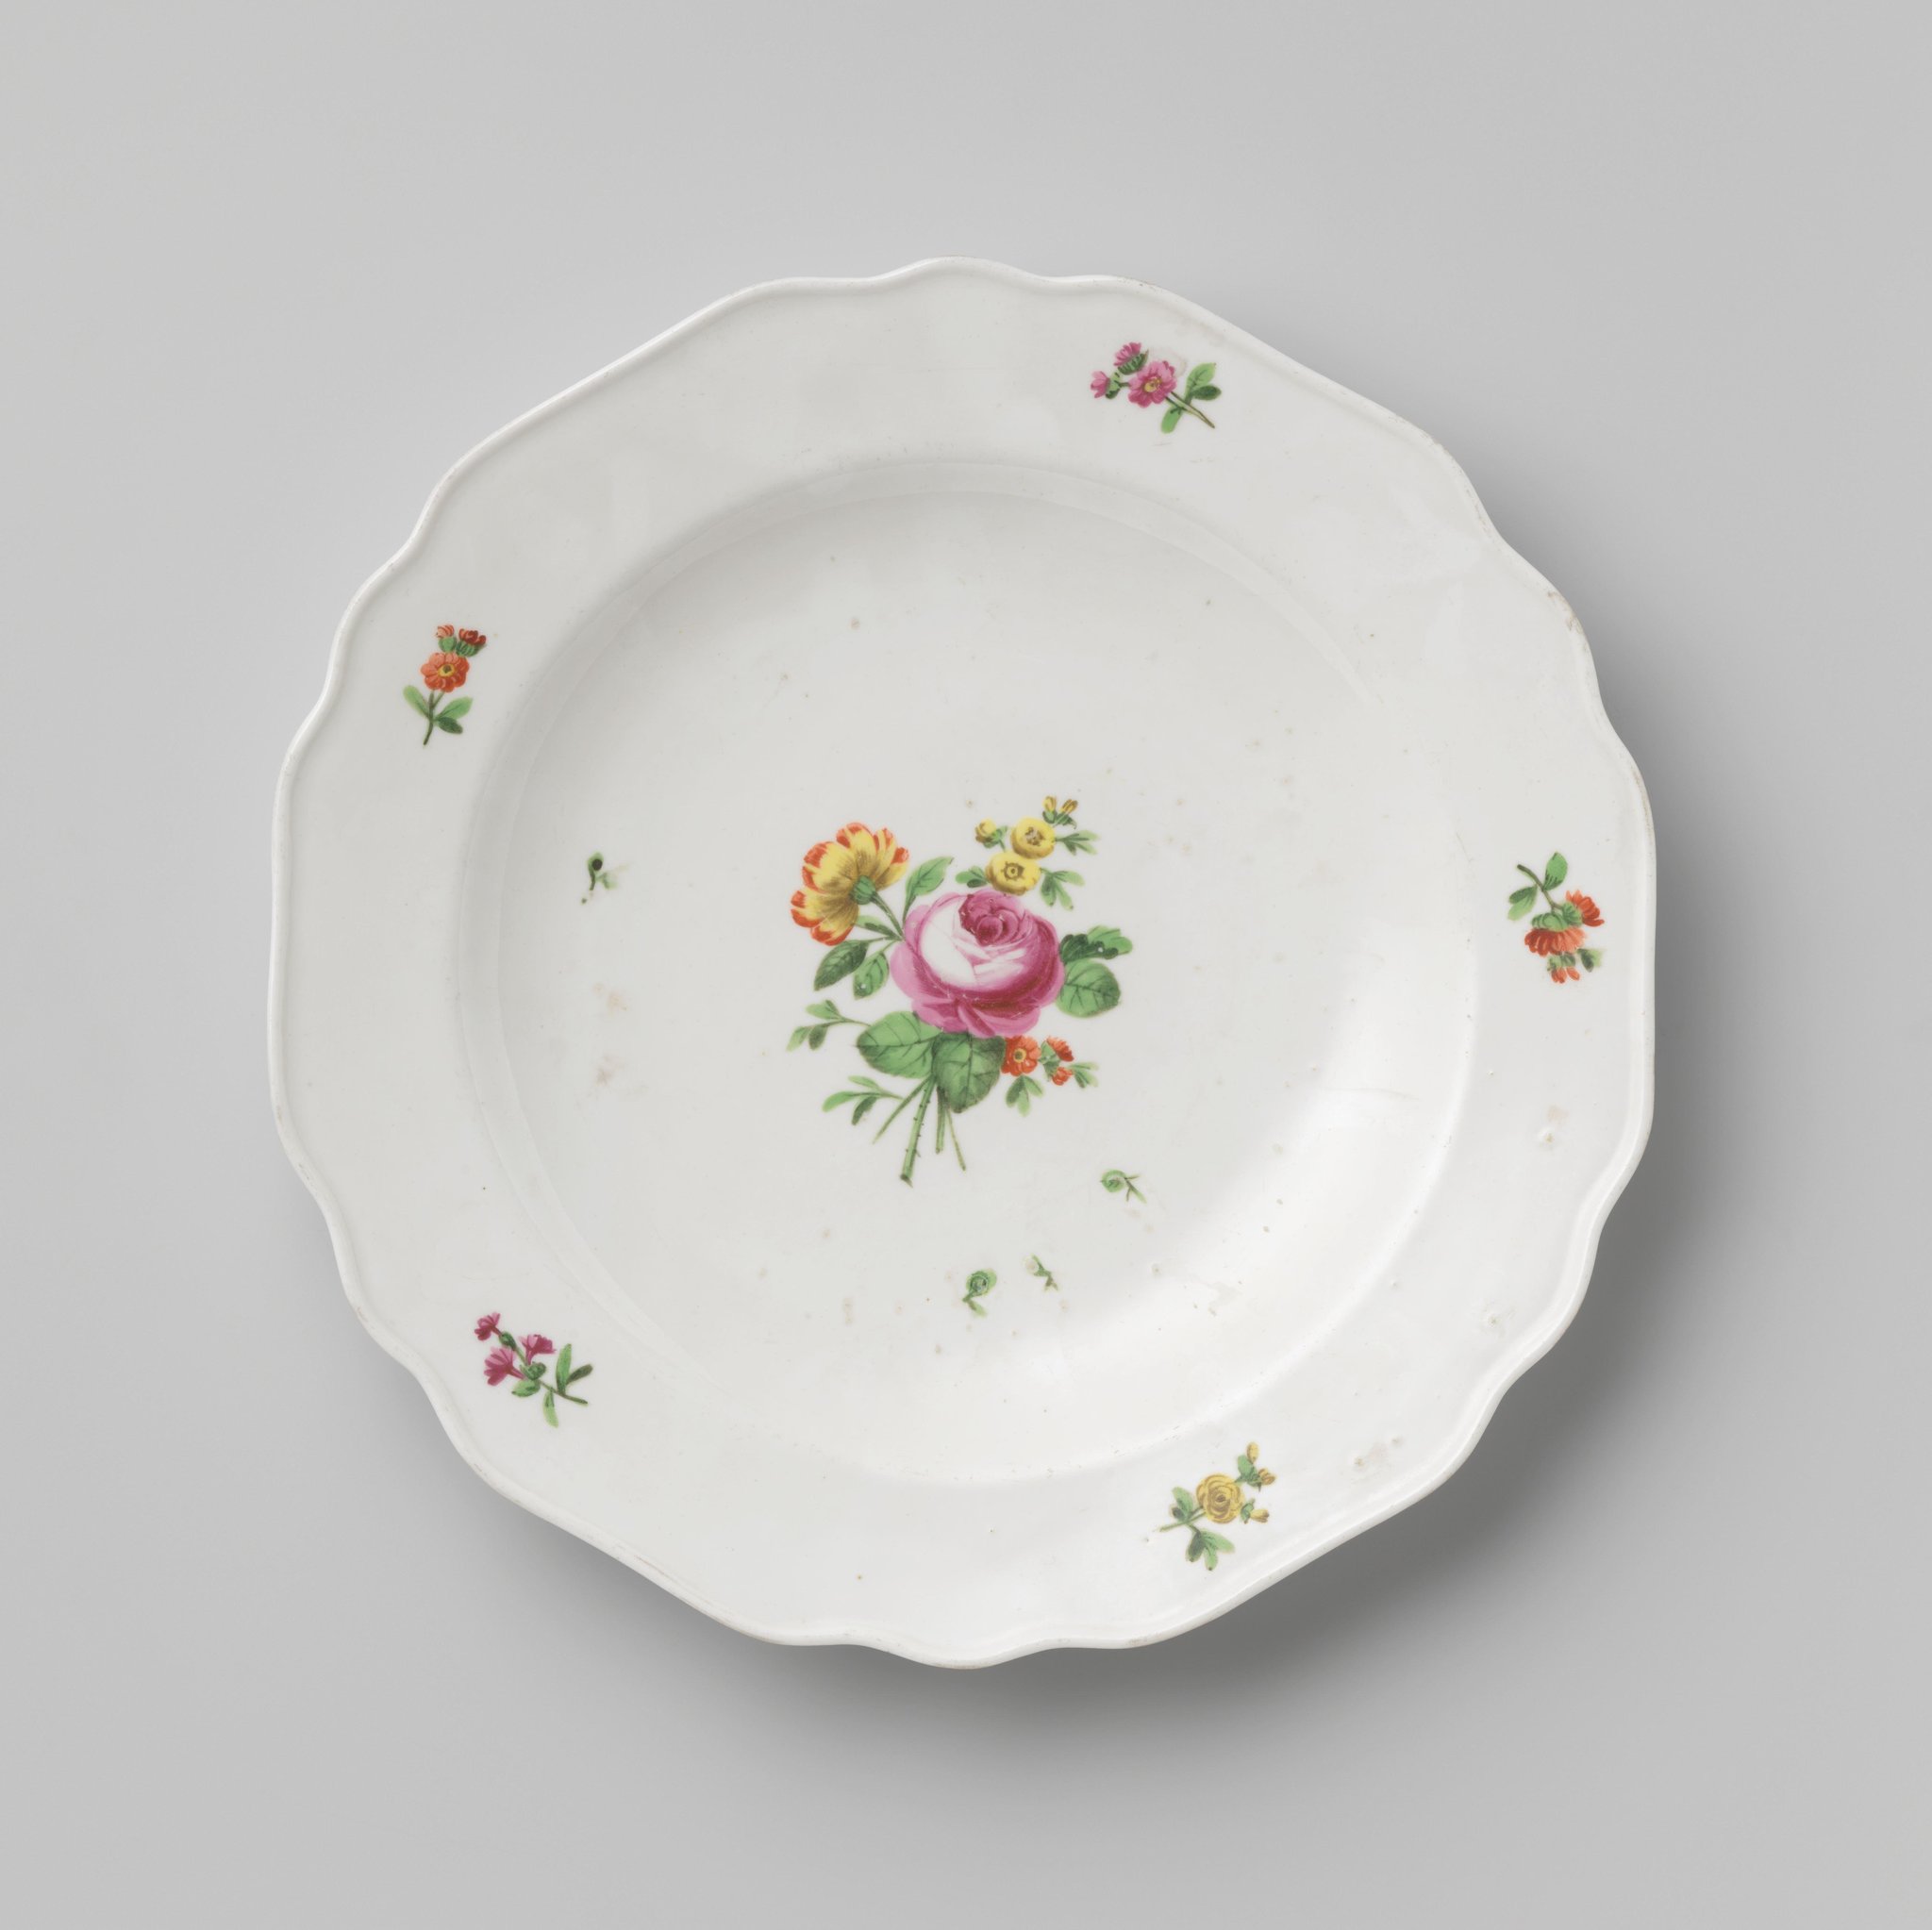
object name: service set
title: Plate with a bouquet and flower sprays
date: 1800-1849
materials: glaze, paint, porcelain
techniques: firing, forming, turning, vitrification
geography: vienna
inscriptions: mark: ‘schild/ F/ 63/ 33/ 87’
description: Bord van porselein met een gelobde rand, beschilderd op het glazuur in rood, roze, groen en geel. Op het plat een boeket van verschillende bloemen (o.a. pioenroos) omgeven door losse takjes en op de rand vijf bloemtakken. Gemerkt op de onderzijde met het schild, de letter F en de nummers 63, 33 en 87.